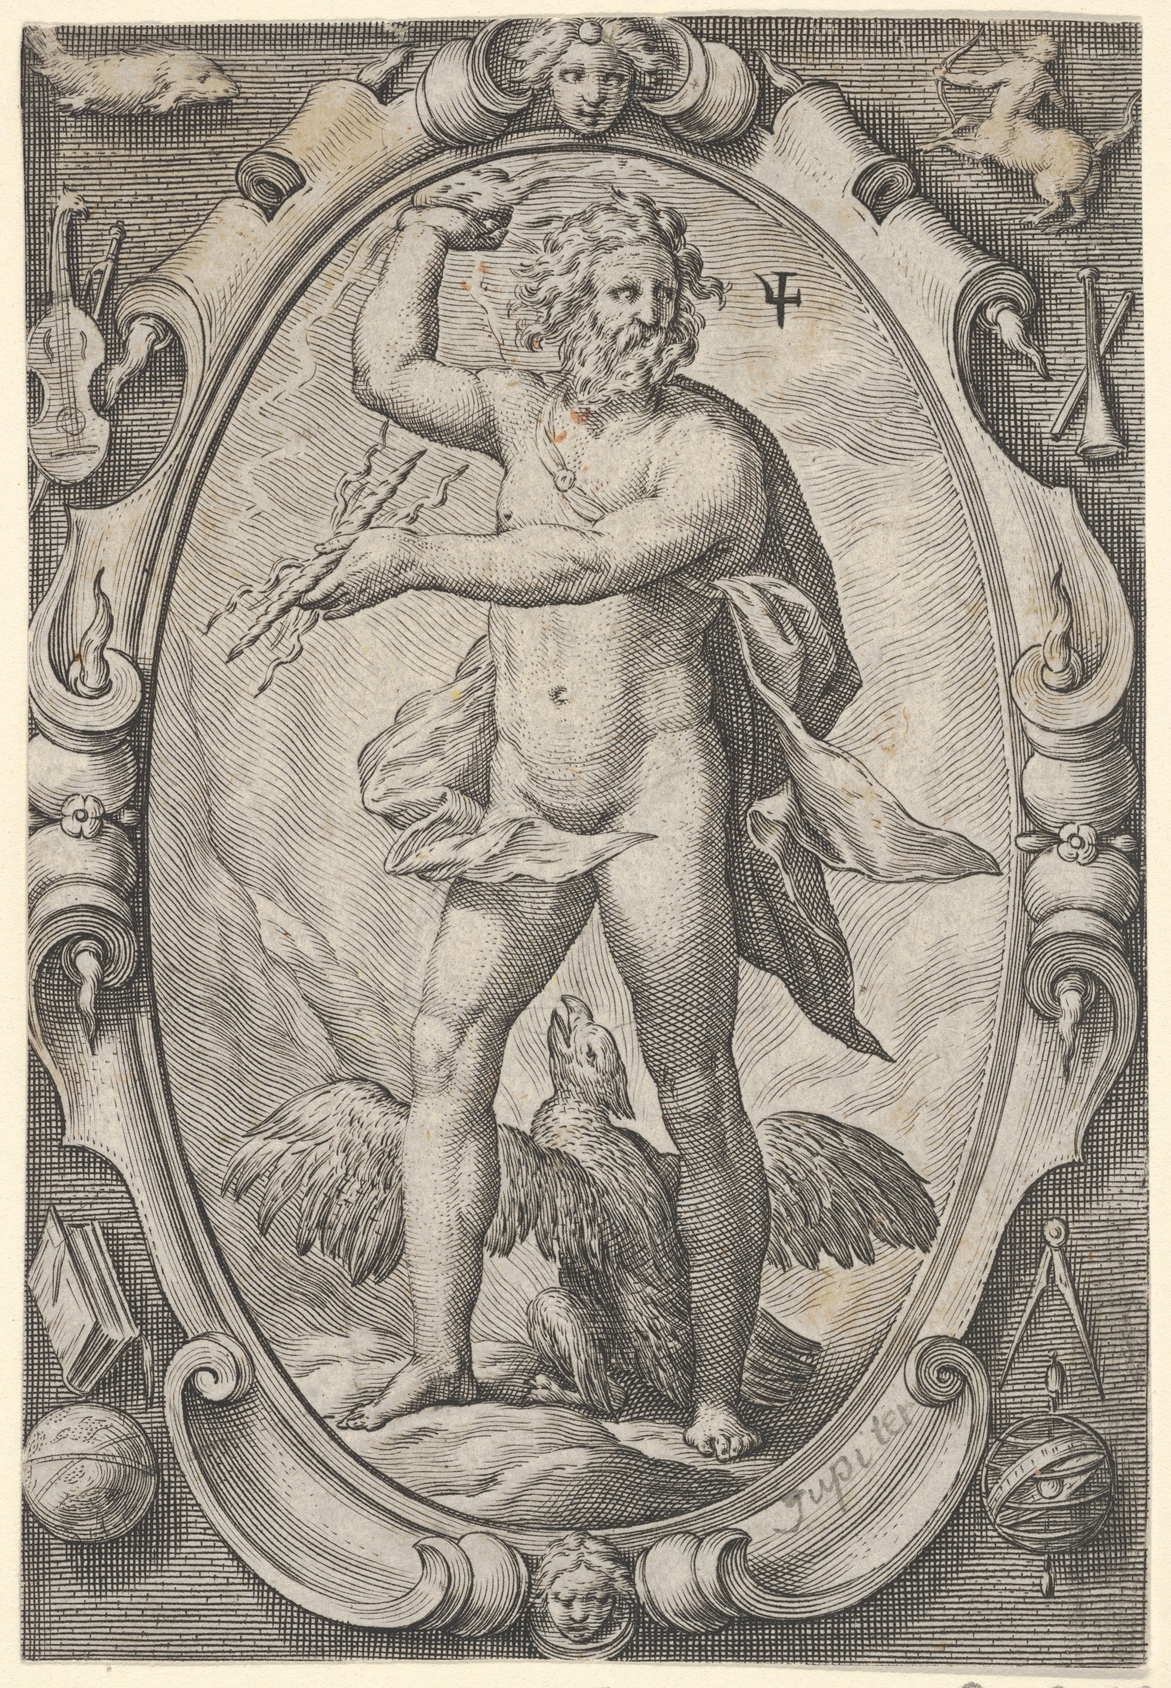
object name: print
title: Jupiter, from "The Planets"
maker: jacob matham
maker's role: artist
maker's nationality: netherlandish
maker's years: 1571-1631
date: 1597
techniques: engraving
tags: eagles,jupiter